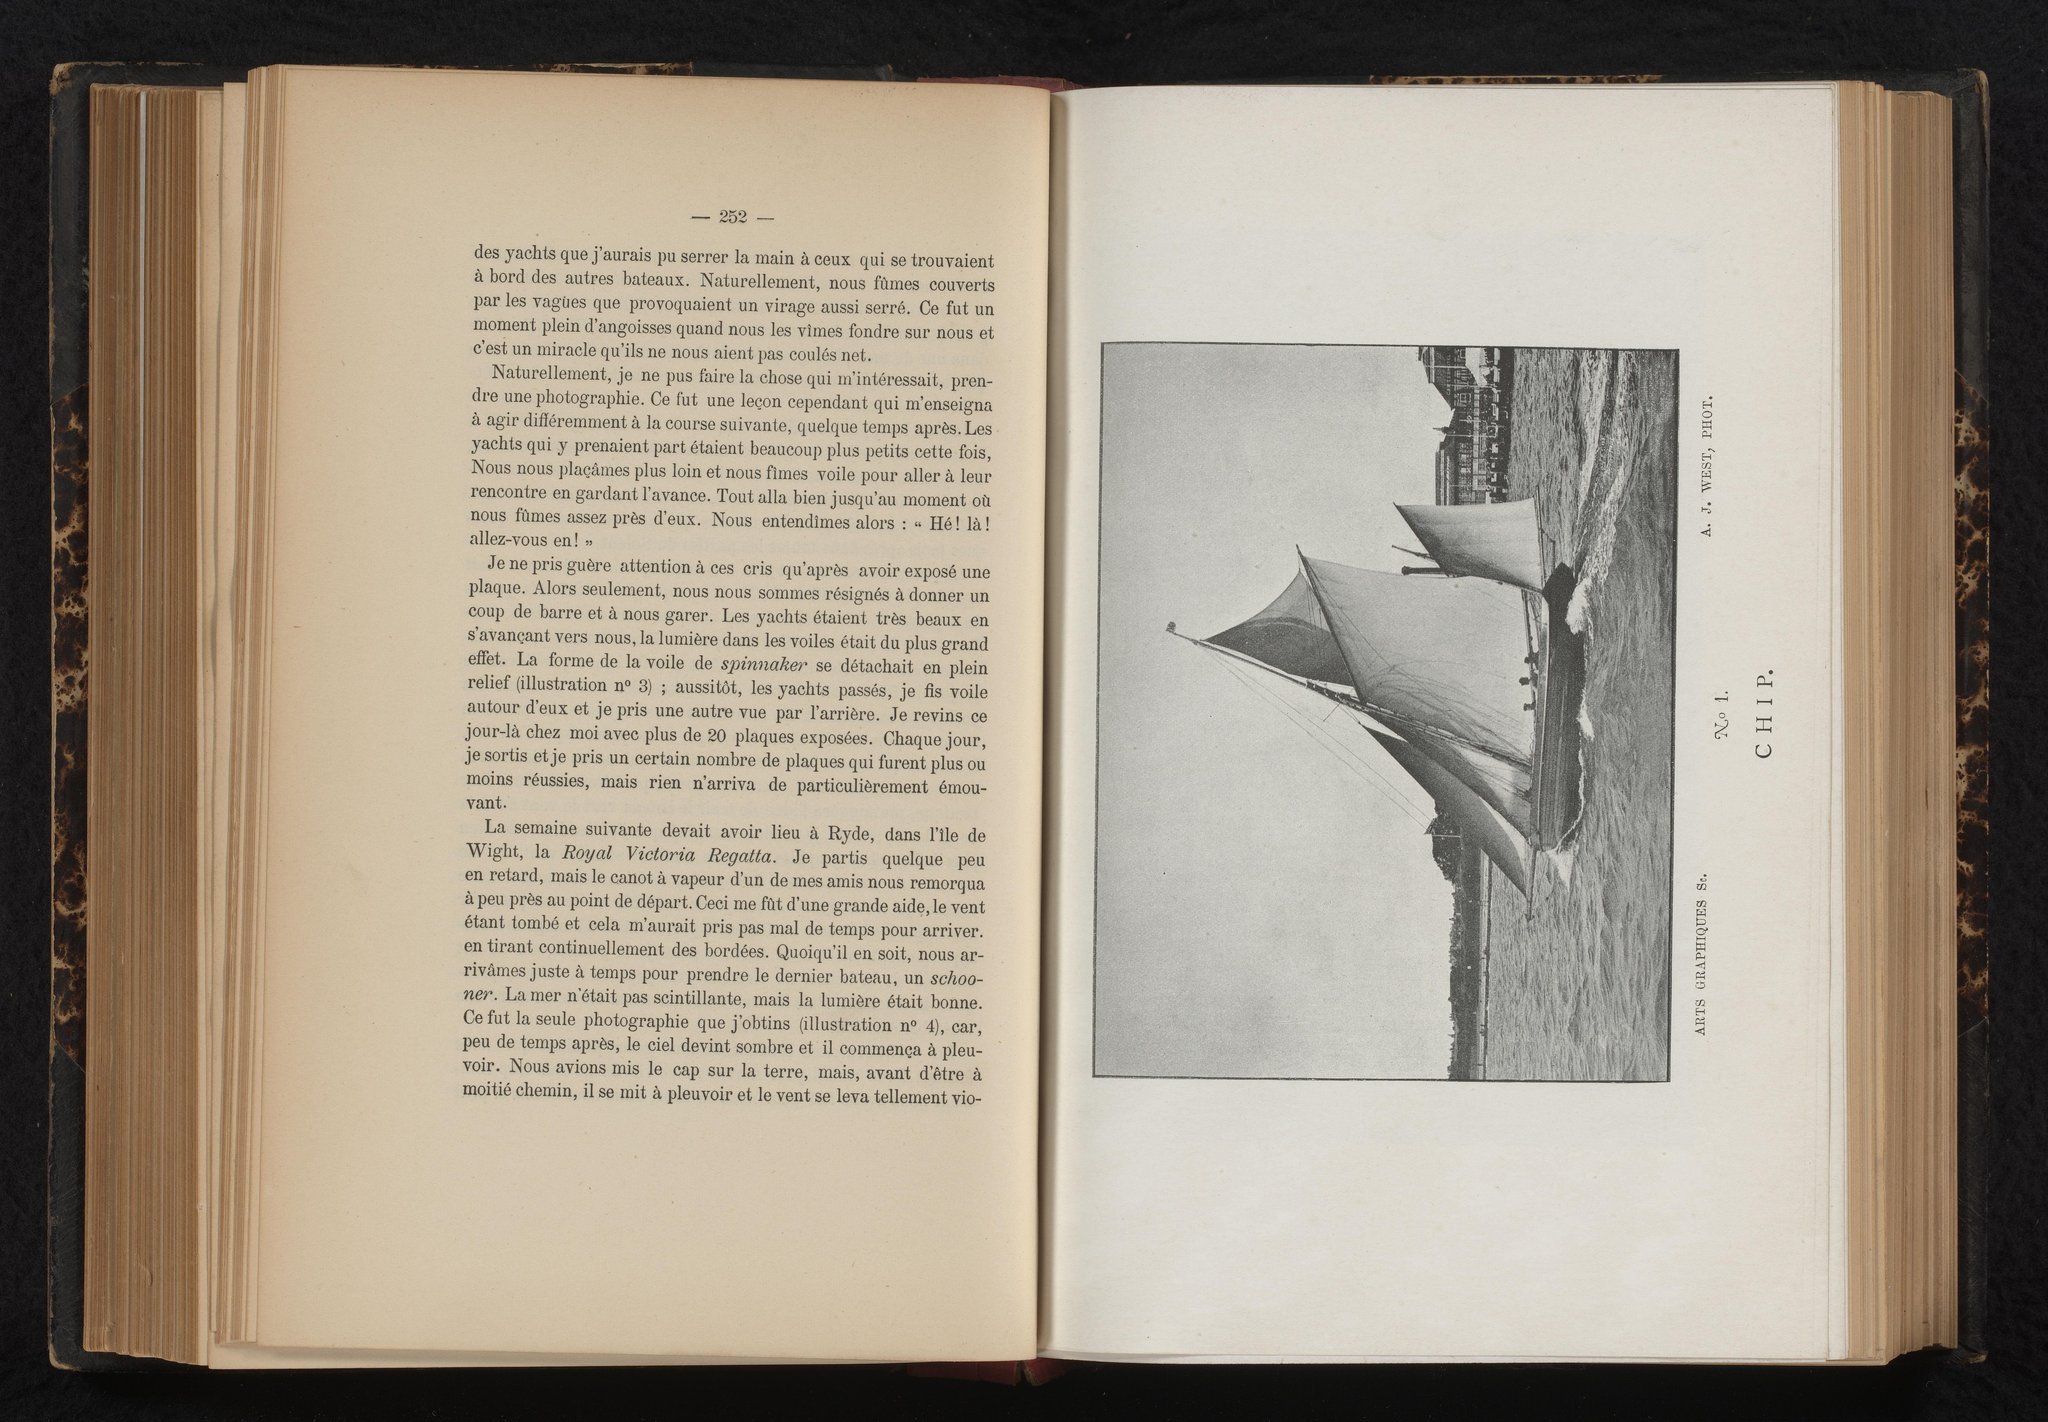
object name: page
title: Chip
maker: a.j. west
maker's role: fotograaf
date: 1881-1886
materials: paper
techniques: photograph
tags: sailing-ship, sailing-boat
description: Prent op ongenummerde pagina tegenover pagina 252.